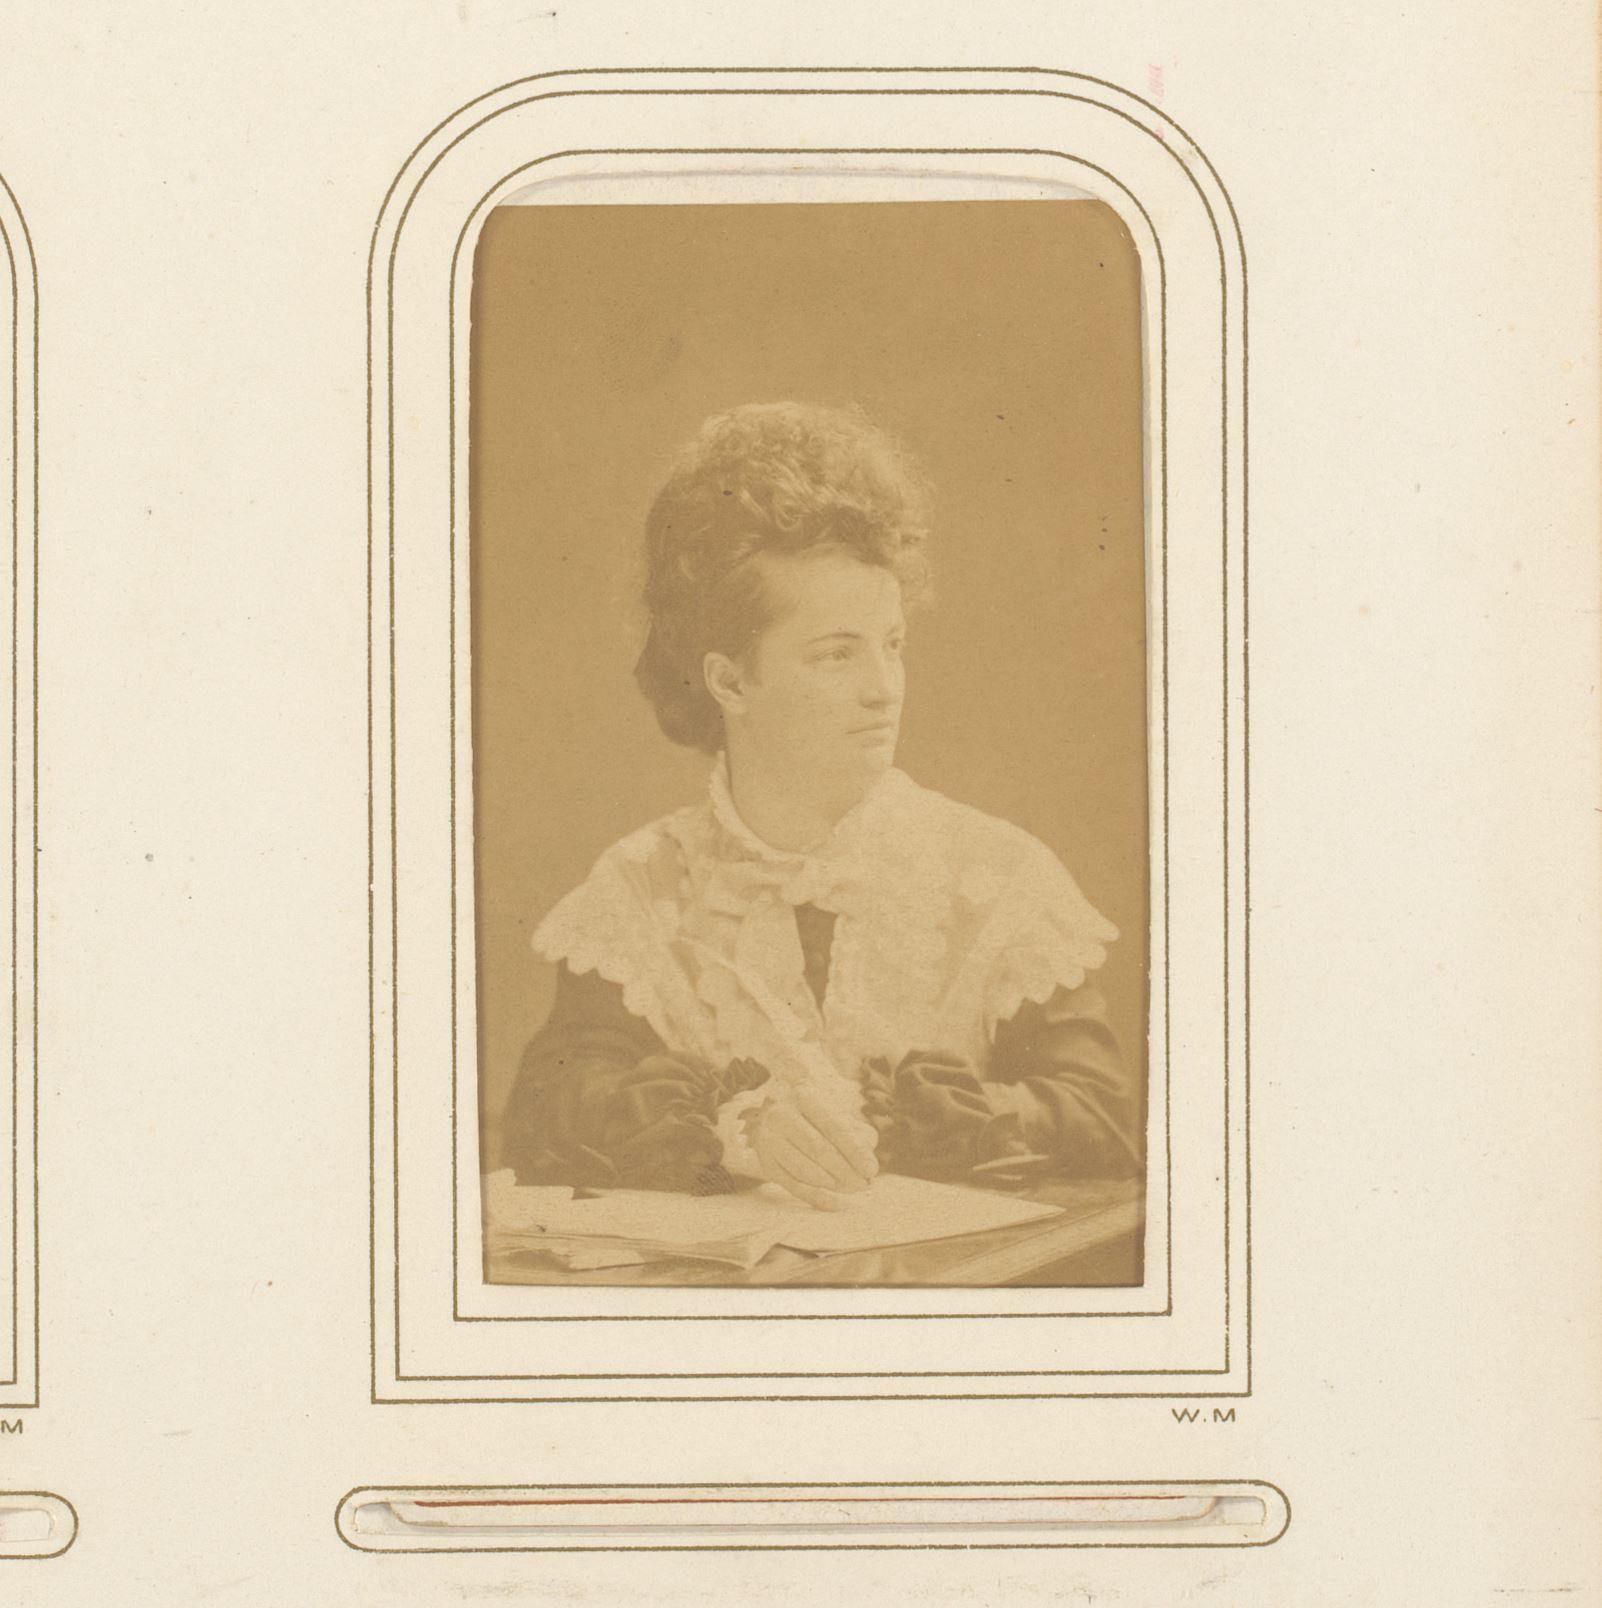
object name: carte de visite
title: Portret van een vrouw, aangeduid als Jenny Braun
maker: waldemar dahllöf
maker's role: fotograaf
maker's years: 1844-1935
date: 1850-1900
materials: cardboard, photographic support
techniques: albumen print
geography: stockholm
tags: historical persons - bb - woman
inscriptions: annotation: ‘[...]ilingen/ i Fa[...]nala[.]’, inscription: ‘Fotografi/ Atelier/ Wald. Dahllöf & Co/ Stockholm/ Bergsgatan 52./ Plåten behålles för efterbeställning.’, annotation: ‘För[...]in[...]/ Jenny Braun’